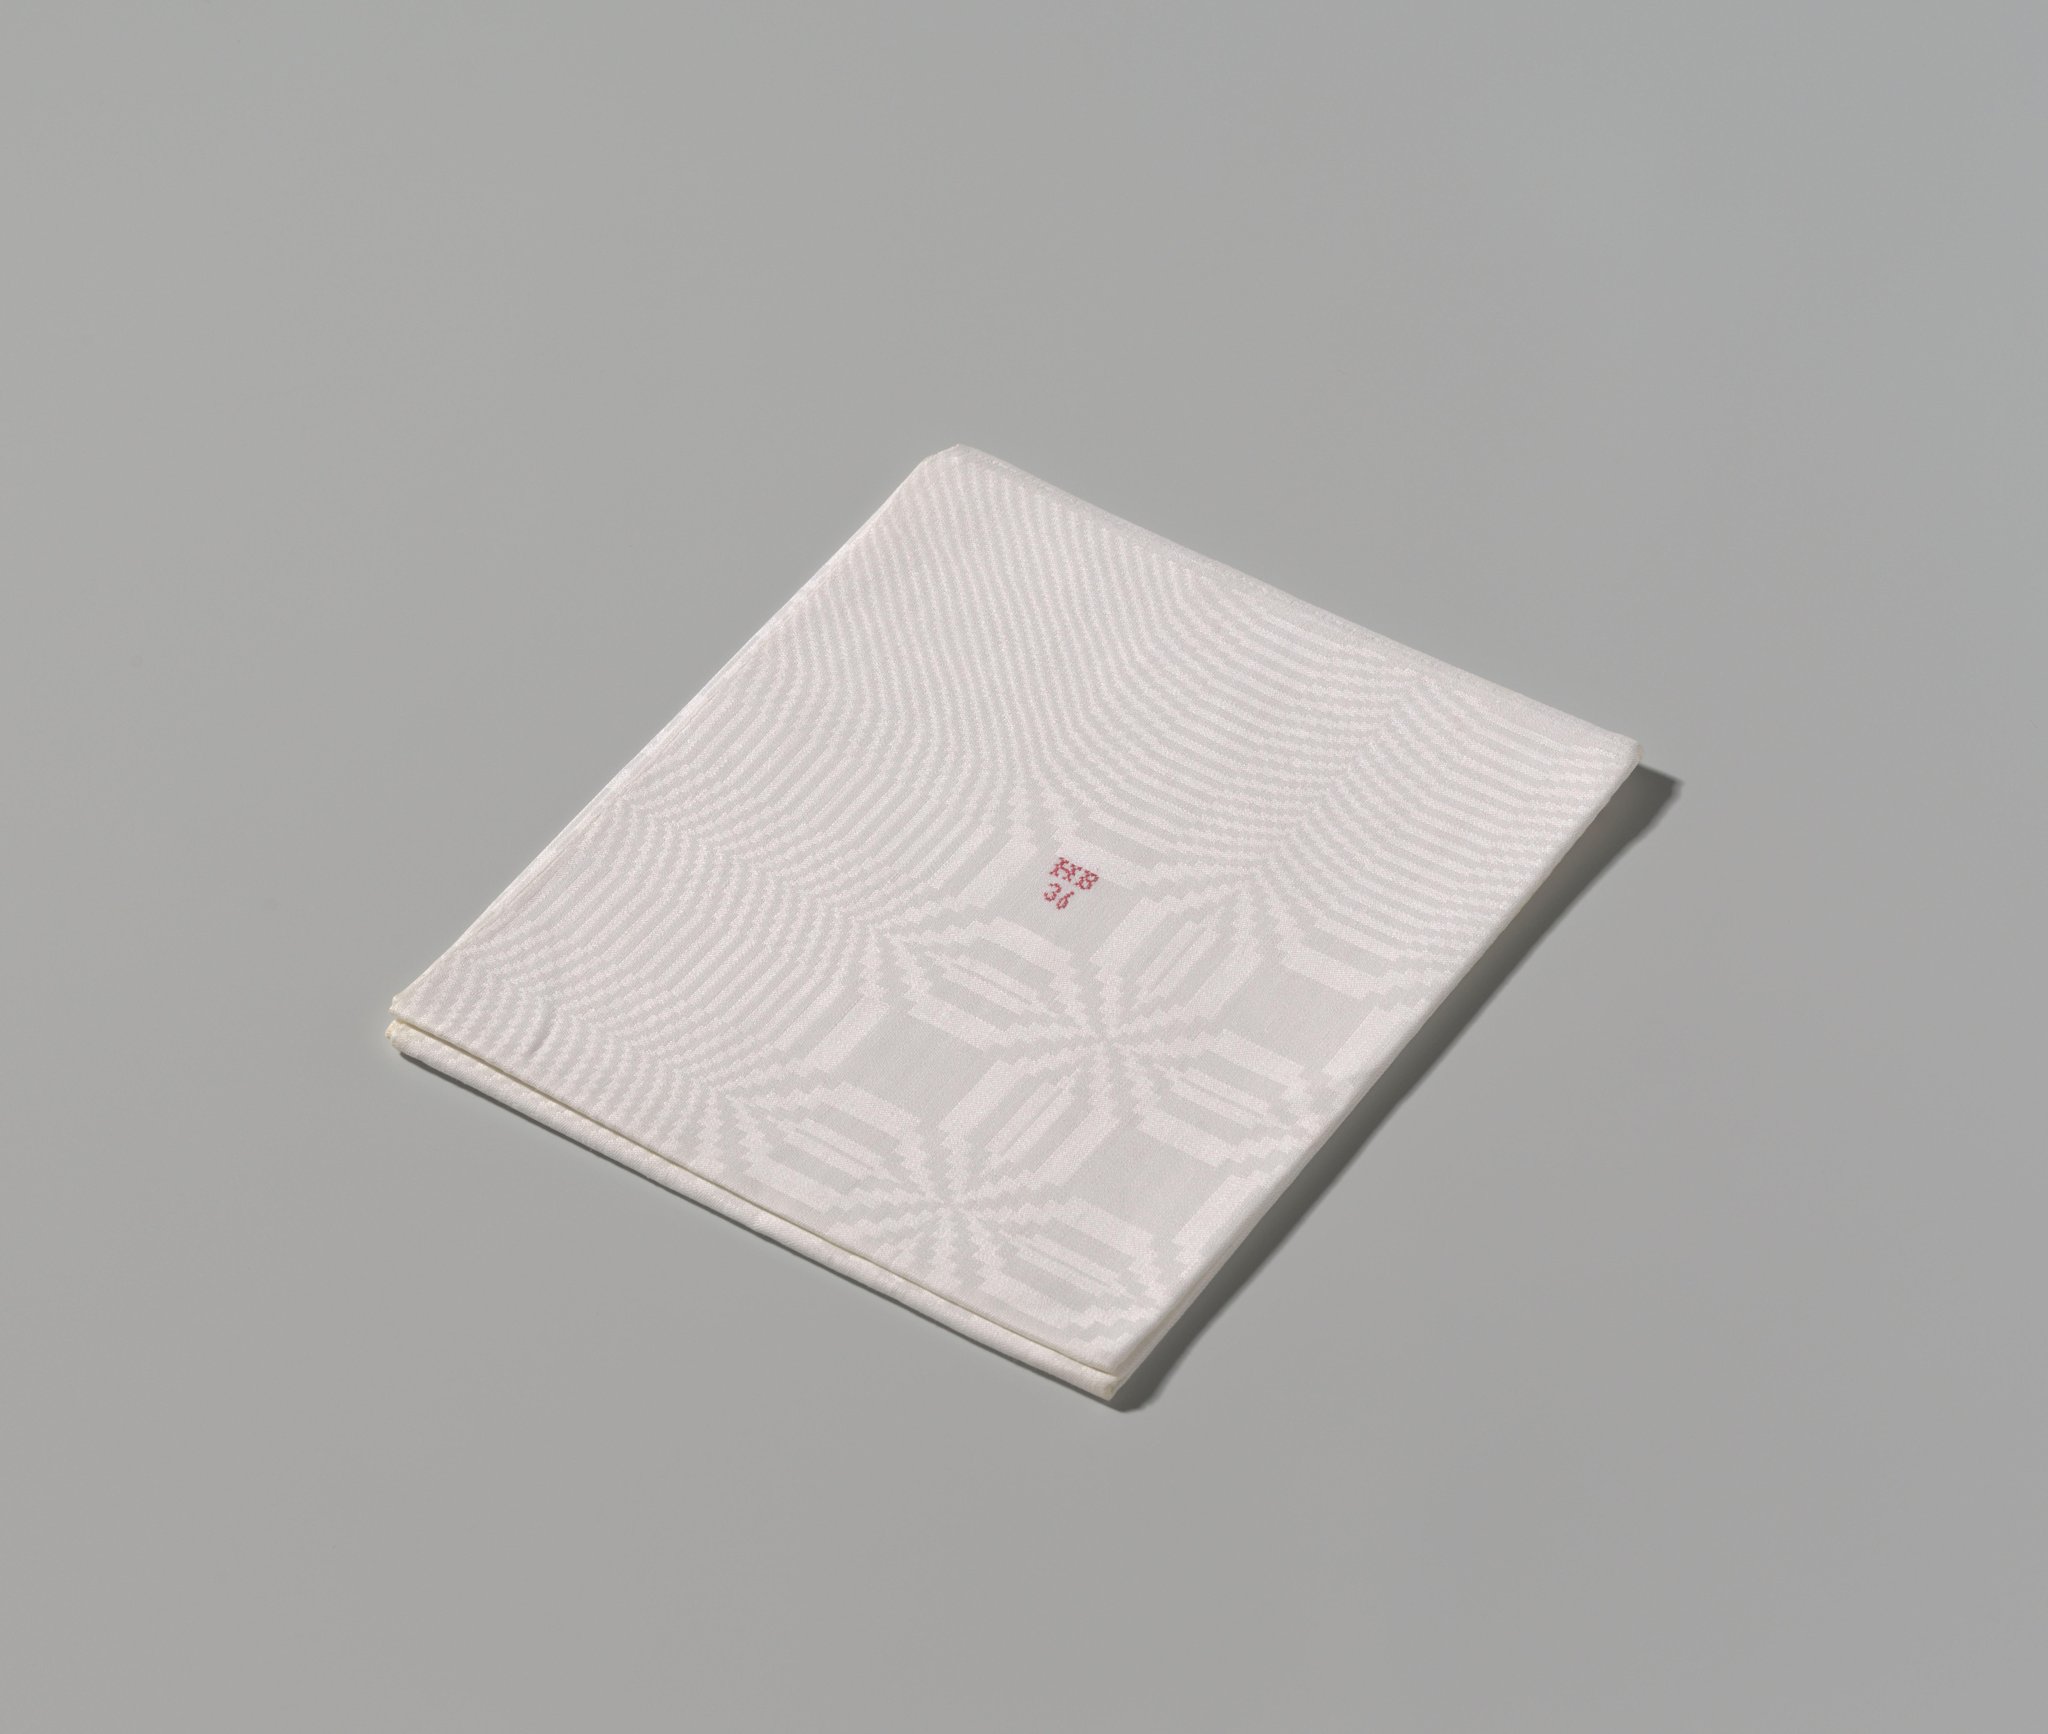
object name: napkin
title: Servet van pellendamast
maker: Anonymous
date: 1907-1925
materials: linen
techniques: weave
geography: netherlands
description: Servet van pellendamast met randen rondom. Het geometrische patroon heeft vierkanten, lijnen en zigzaggende lijnen. De randen zijn gestreept. Het servet is in rood gemerkt met een kruissteek: HB 36.